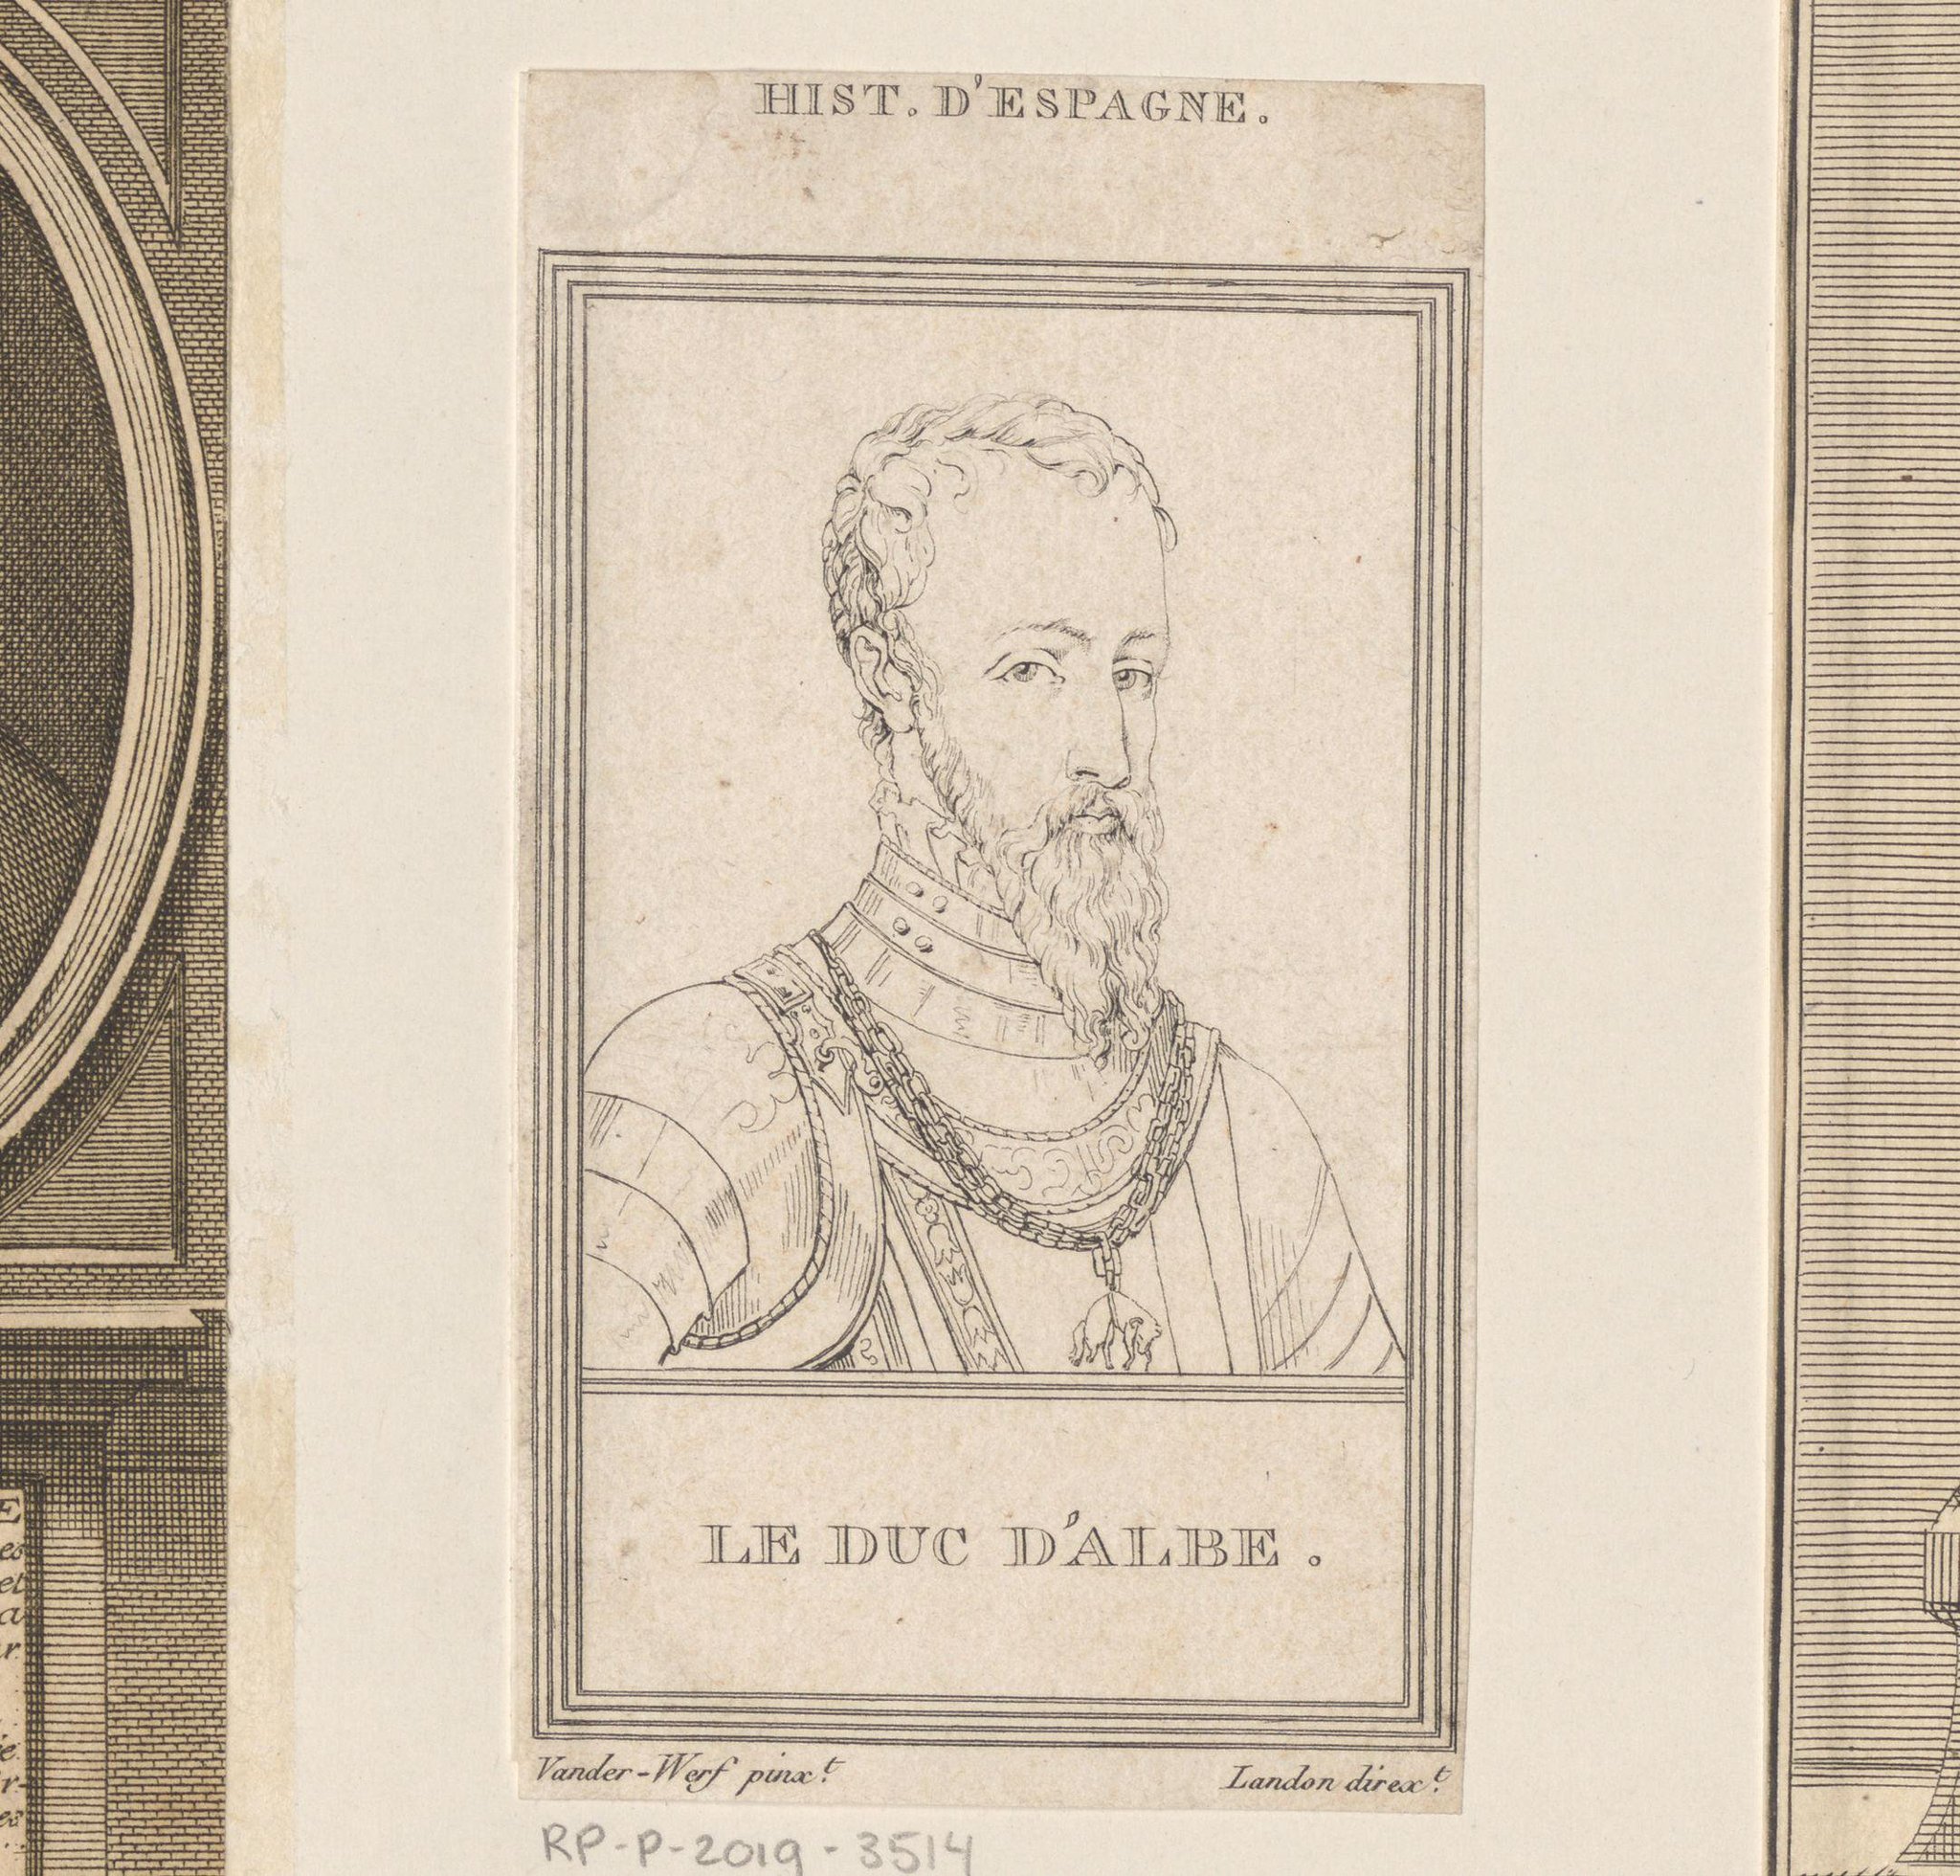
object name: print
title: Portret van Fernando Álvarez de Toledo, hertog van Alva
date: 1805-1811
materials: paper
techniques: etching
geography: paris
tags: fernando álvarez de toledo (3rd duke of alba), armour, historical persons, knighthood order of the golden fleece - insignia of a knighthood order, e.g.: badge, chain (with name of order)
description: Prent uit: Galerie historique des hommes les plus célèbres (...). Parijs: Charles Paul Landon, 1805-1811.